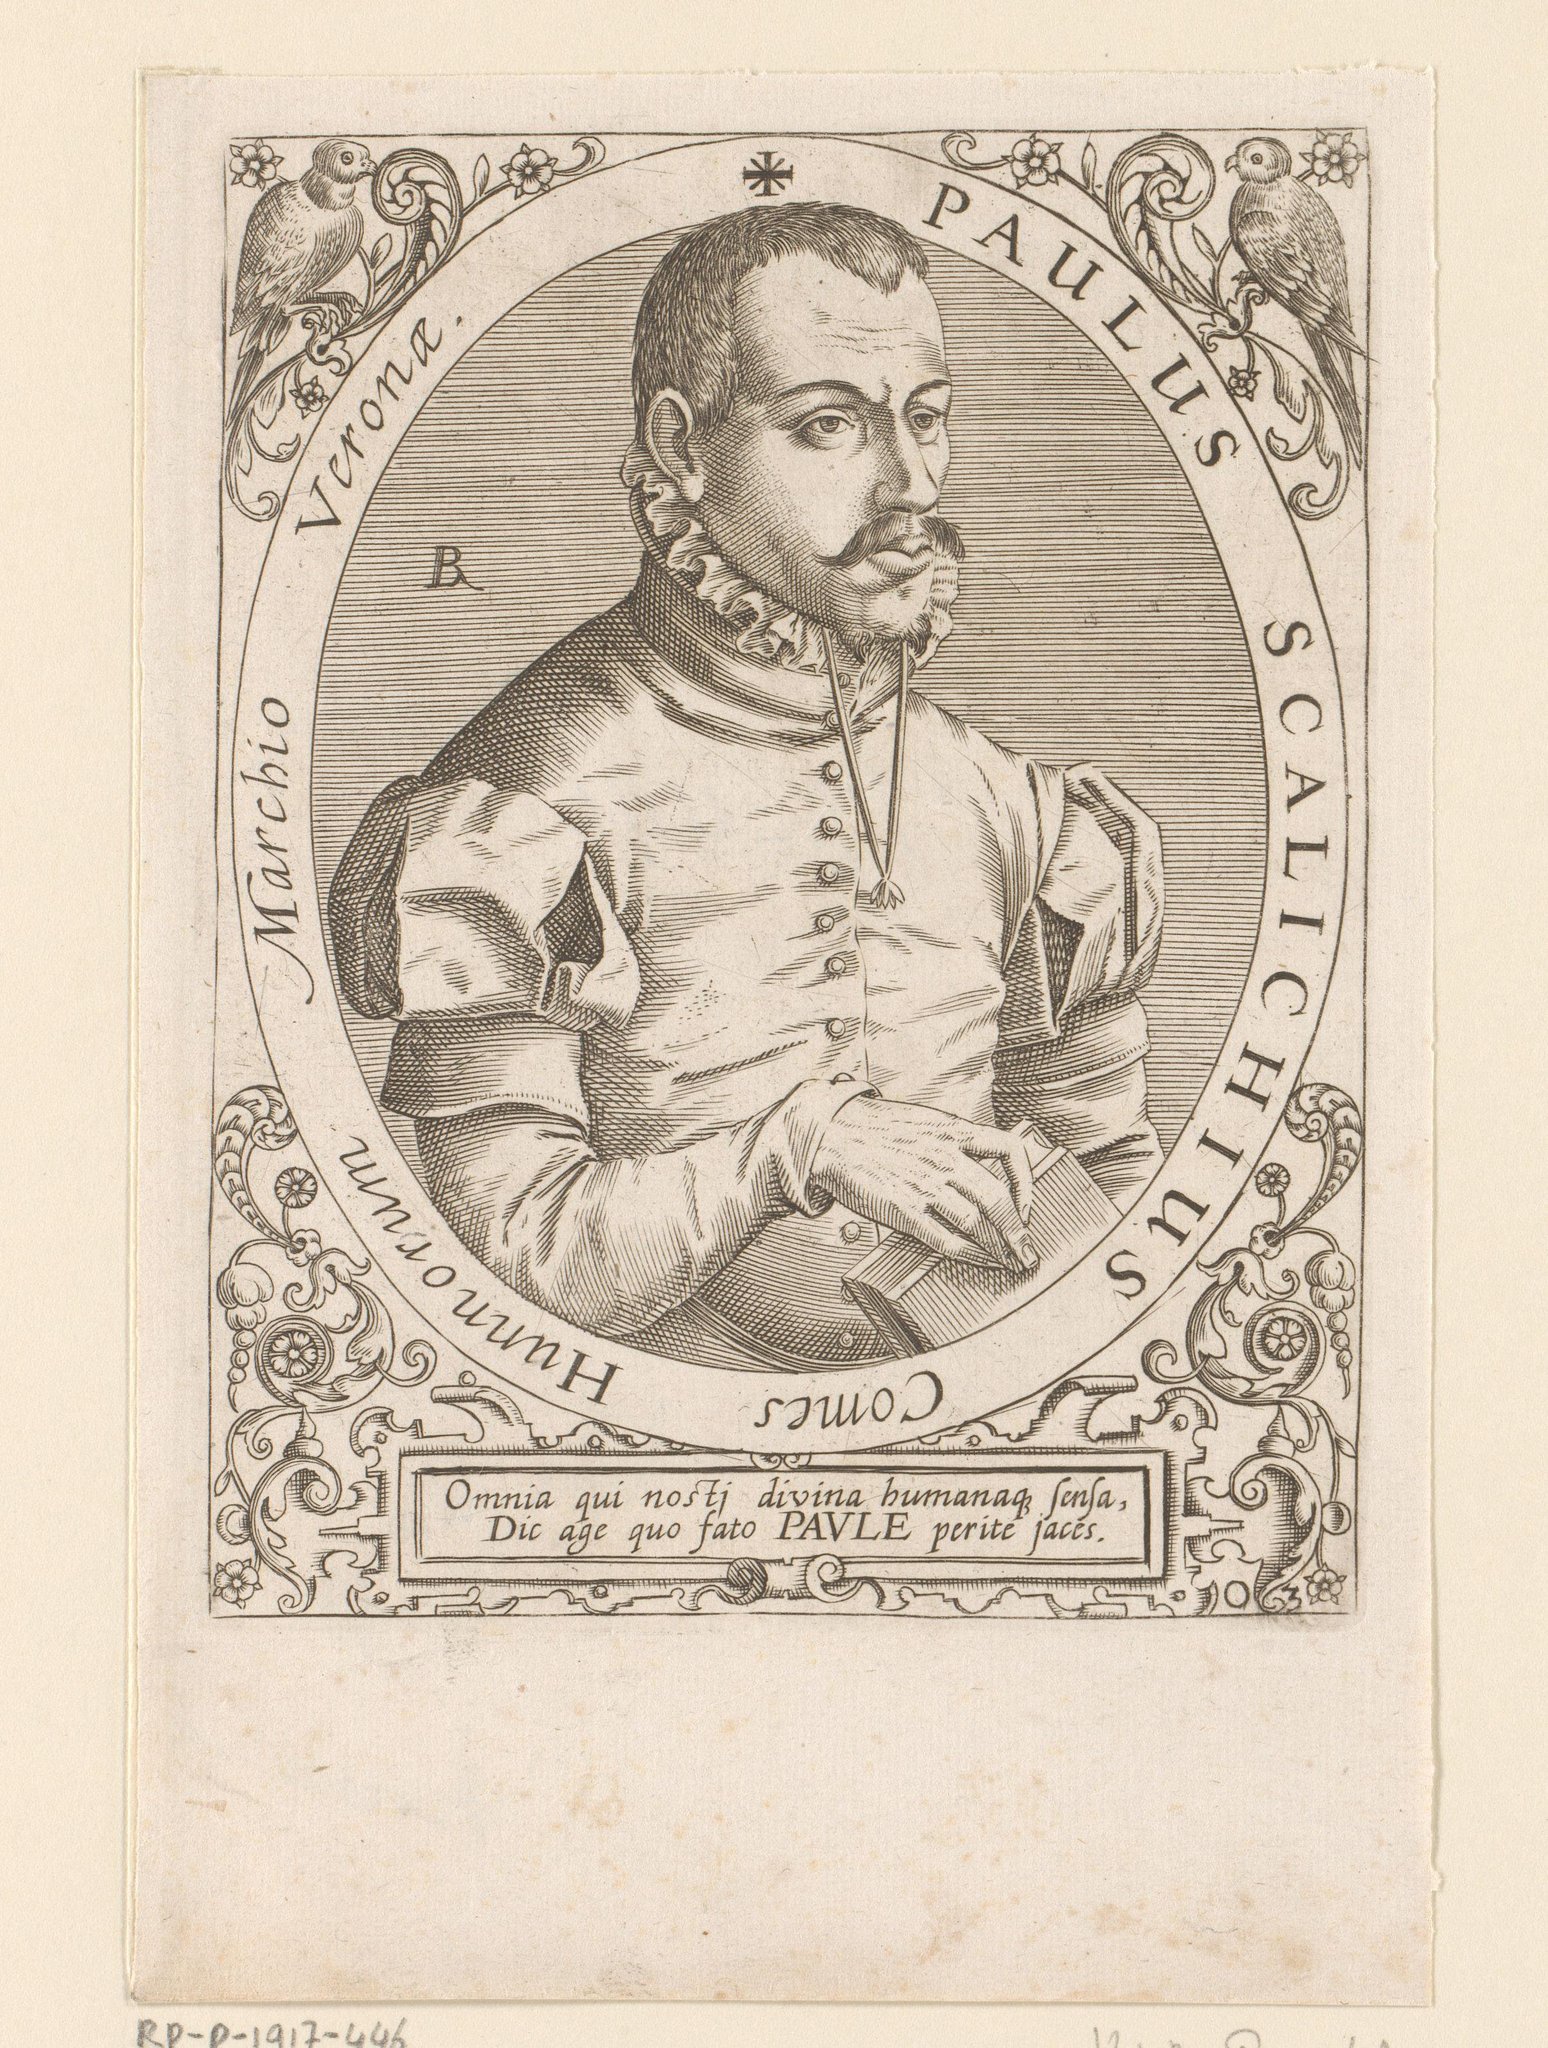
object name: print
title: Paulus Scalichius comes hunnorum marchio Veronae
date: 1650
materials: paper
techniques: engraving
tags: historical persons, organization, functionaries and dignitaries in roman catholic church; clergy in general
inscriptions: collector's mark: Lugt 2228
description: Prent gebruikt in: Boissard, Jean Jacques. Bibliotheca chalcographica. 8 dln. Frankfurt am Main: Johannes Ammon, 1650-1652. Ook gebruikt in latere edities. Eerdere staat van prent verschenen in: Boissard, Jean Jacques. Icones quinquaginta virorum illustrium doctrina & eruditione praestantium ad vivum effictae. 4 dln. Frankfurt am Main: s.n., 1597-1599. Mogelijk ook gebruikt in latere edities.